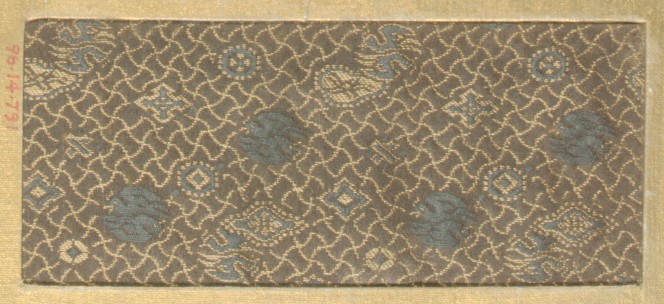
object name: piece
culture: japanese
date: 1701-1900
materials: silk